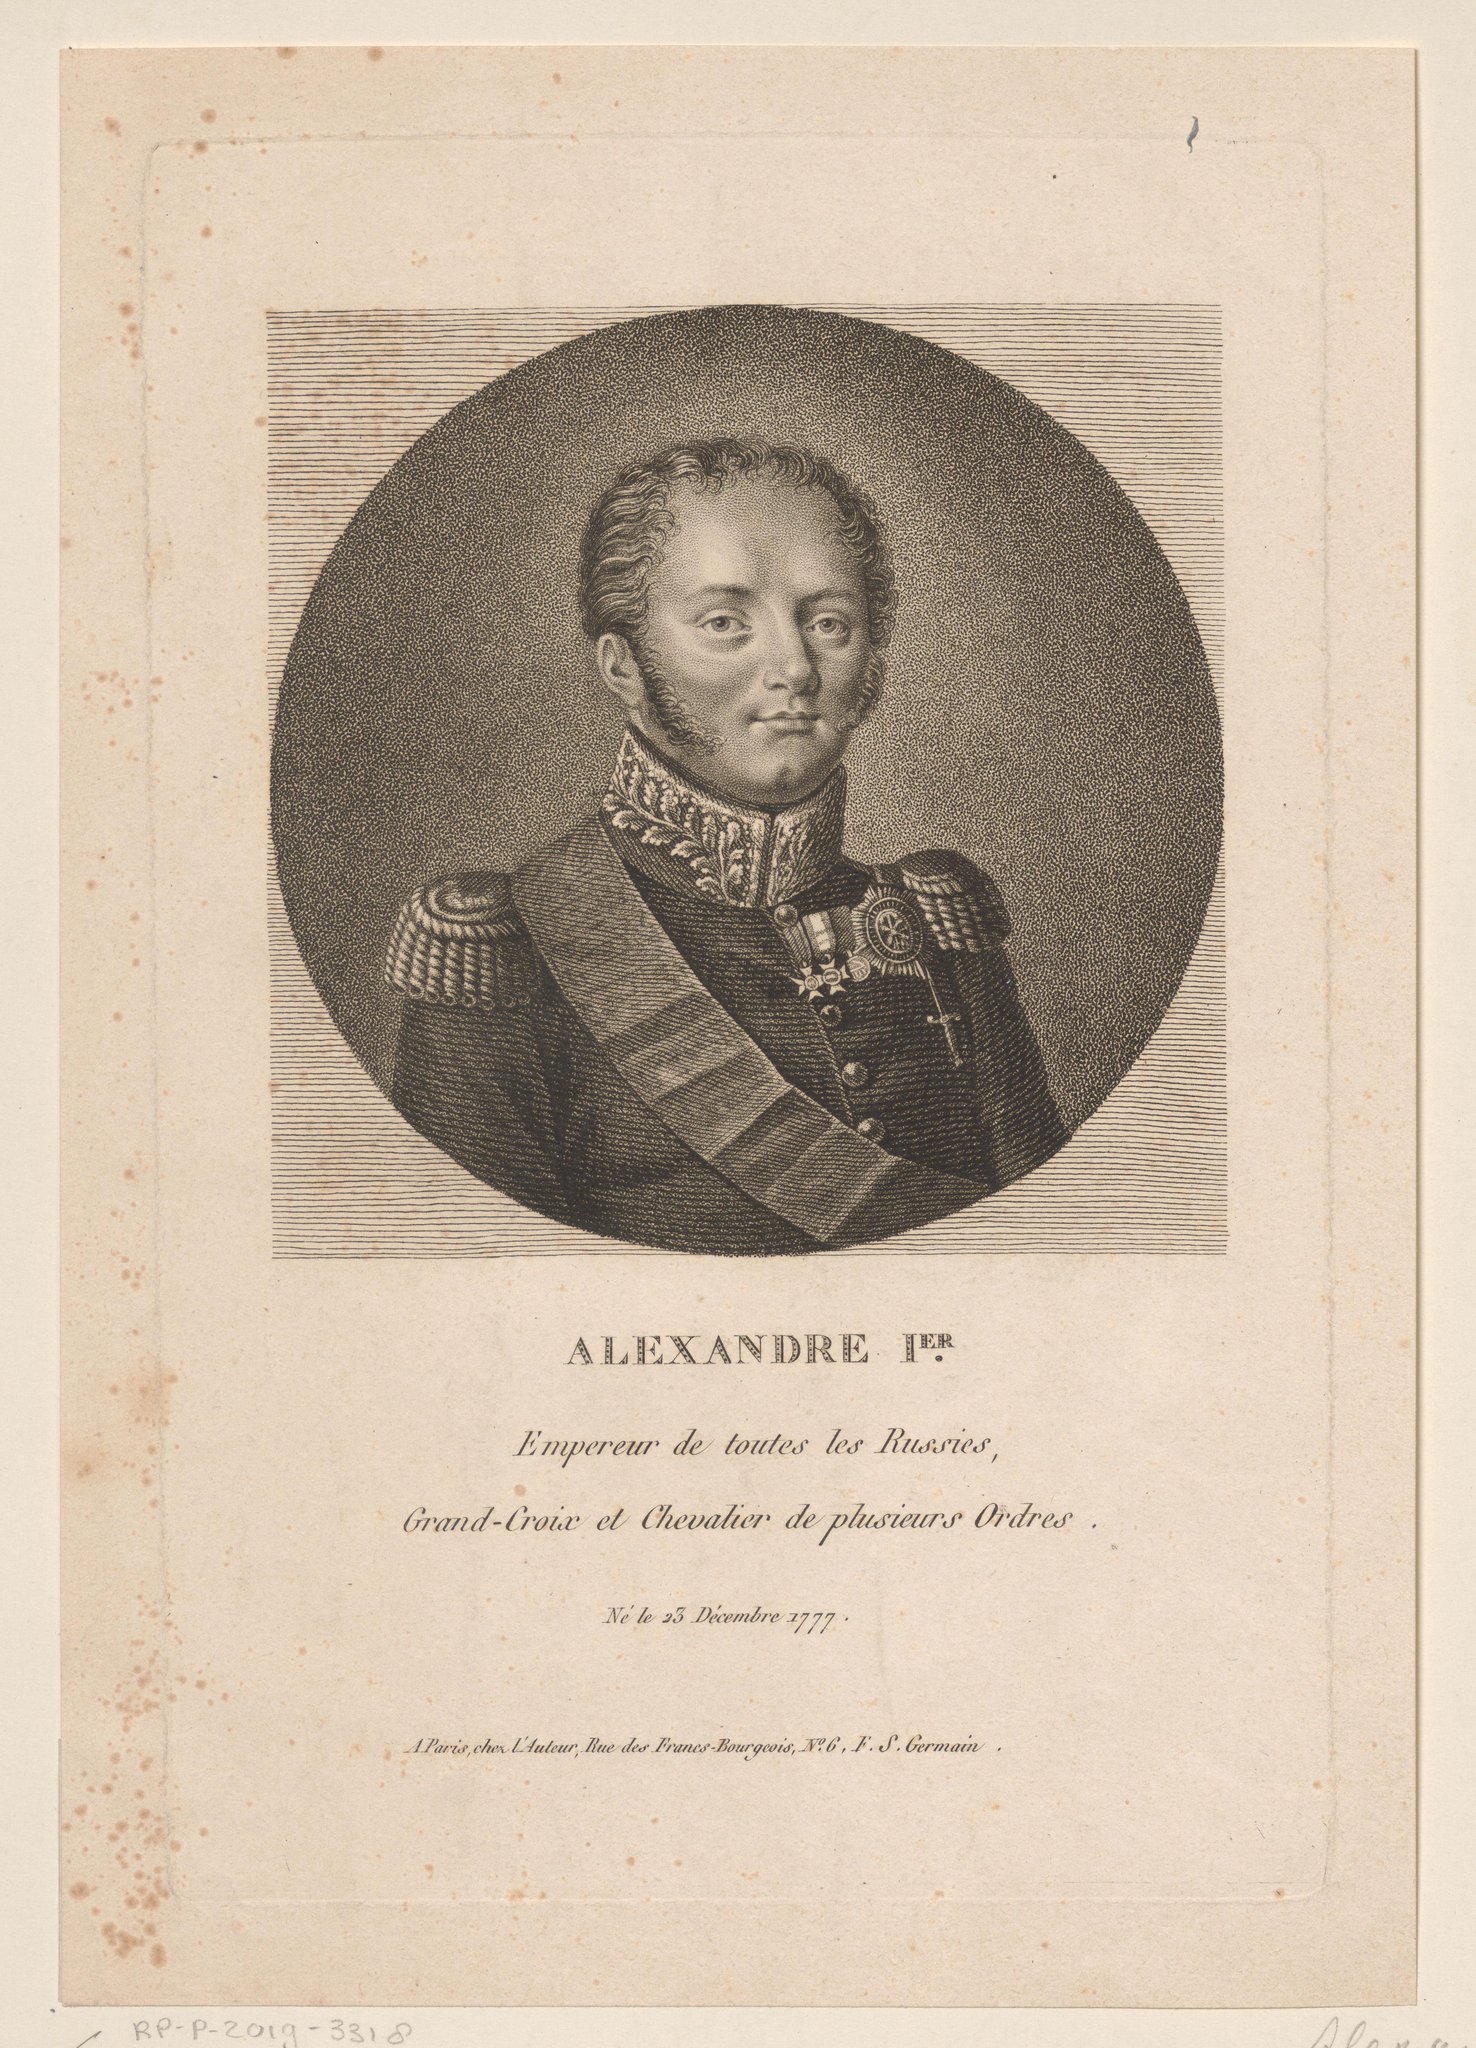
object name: print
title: Portret van Alexander I, tsaar van Rusland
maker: Anonymous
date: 1801-1850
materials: paper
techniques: etching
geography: théâtre des folies-marigny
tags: alexander i (tsaar van rusland), historical persons, emperor